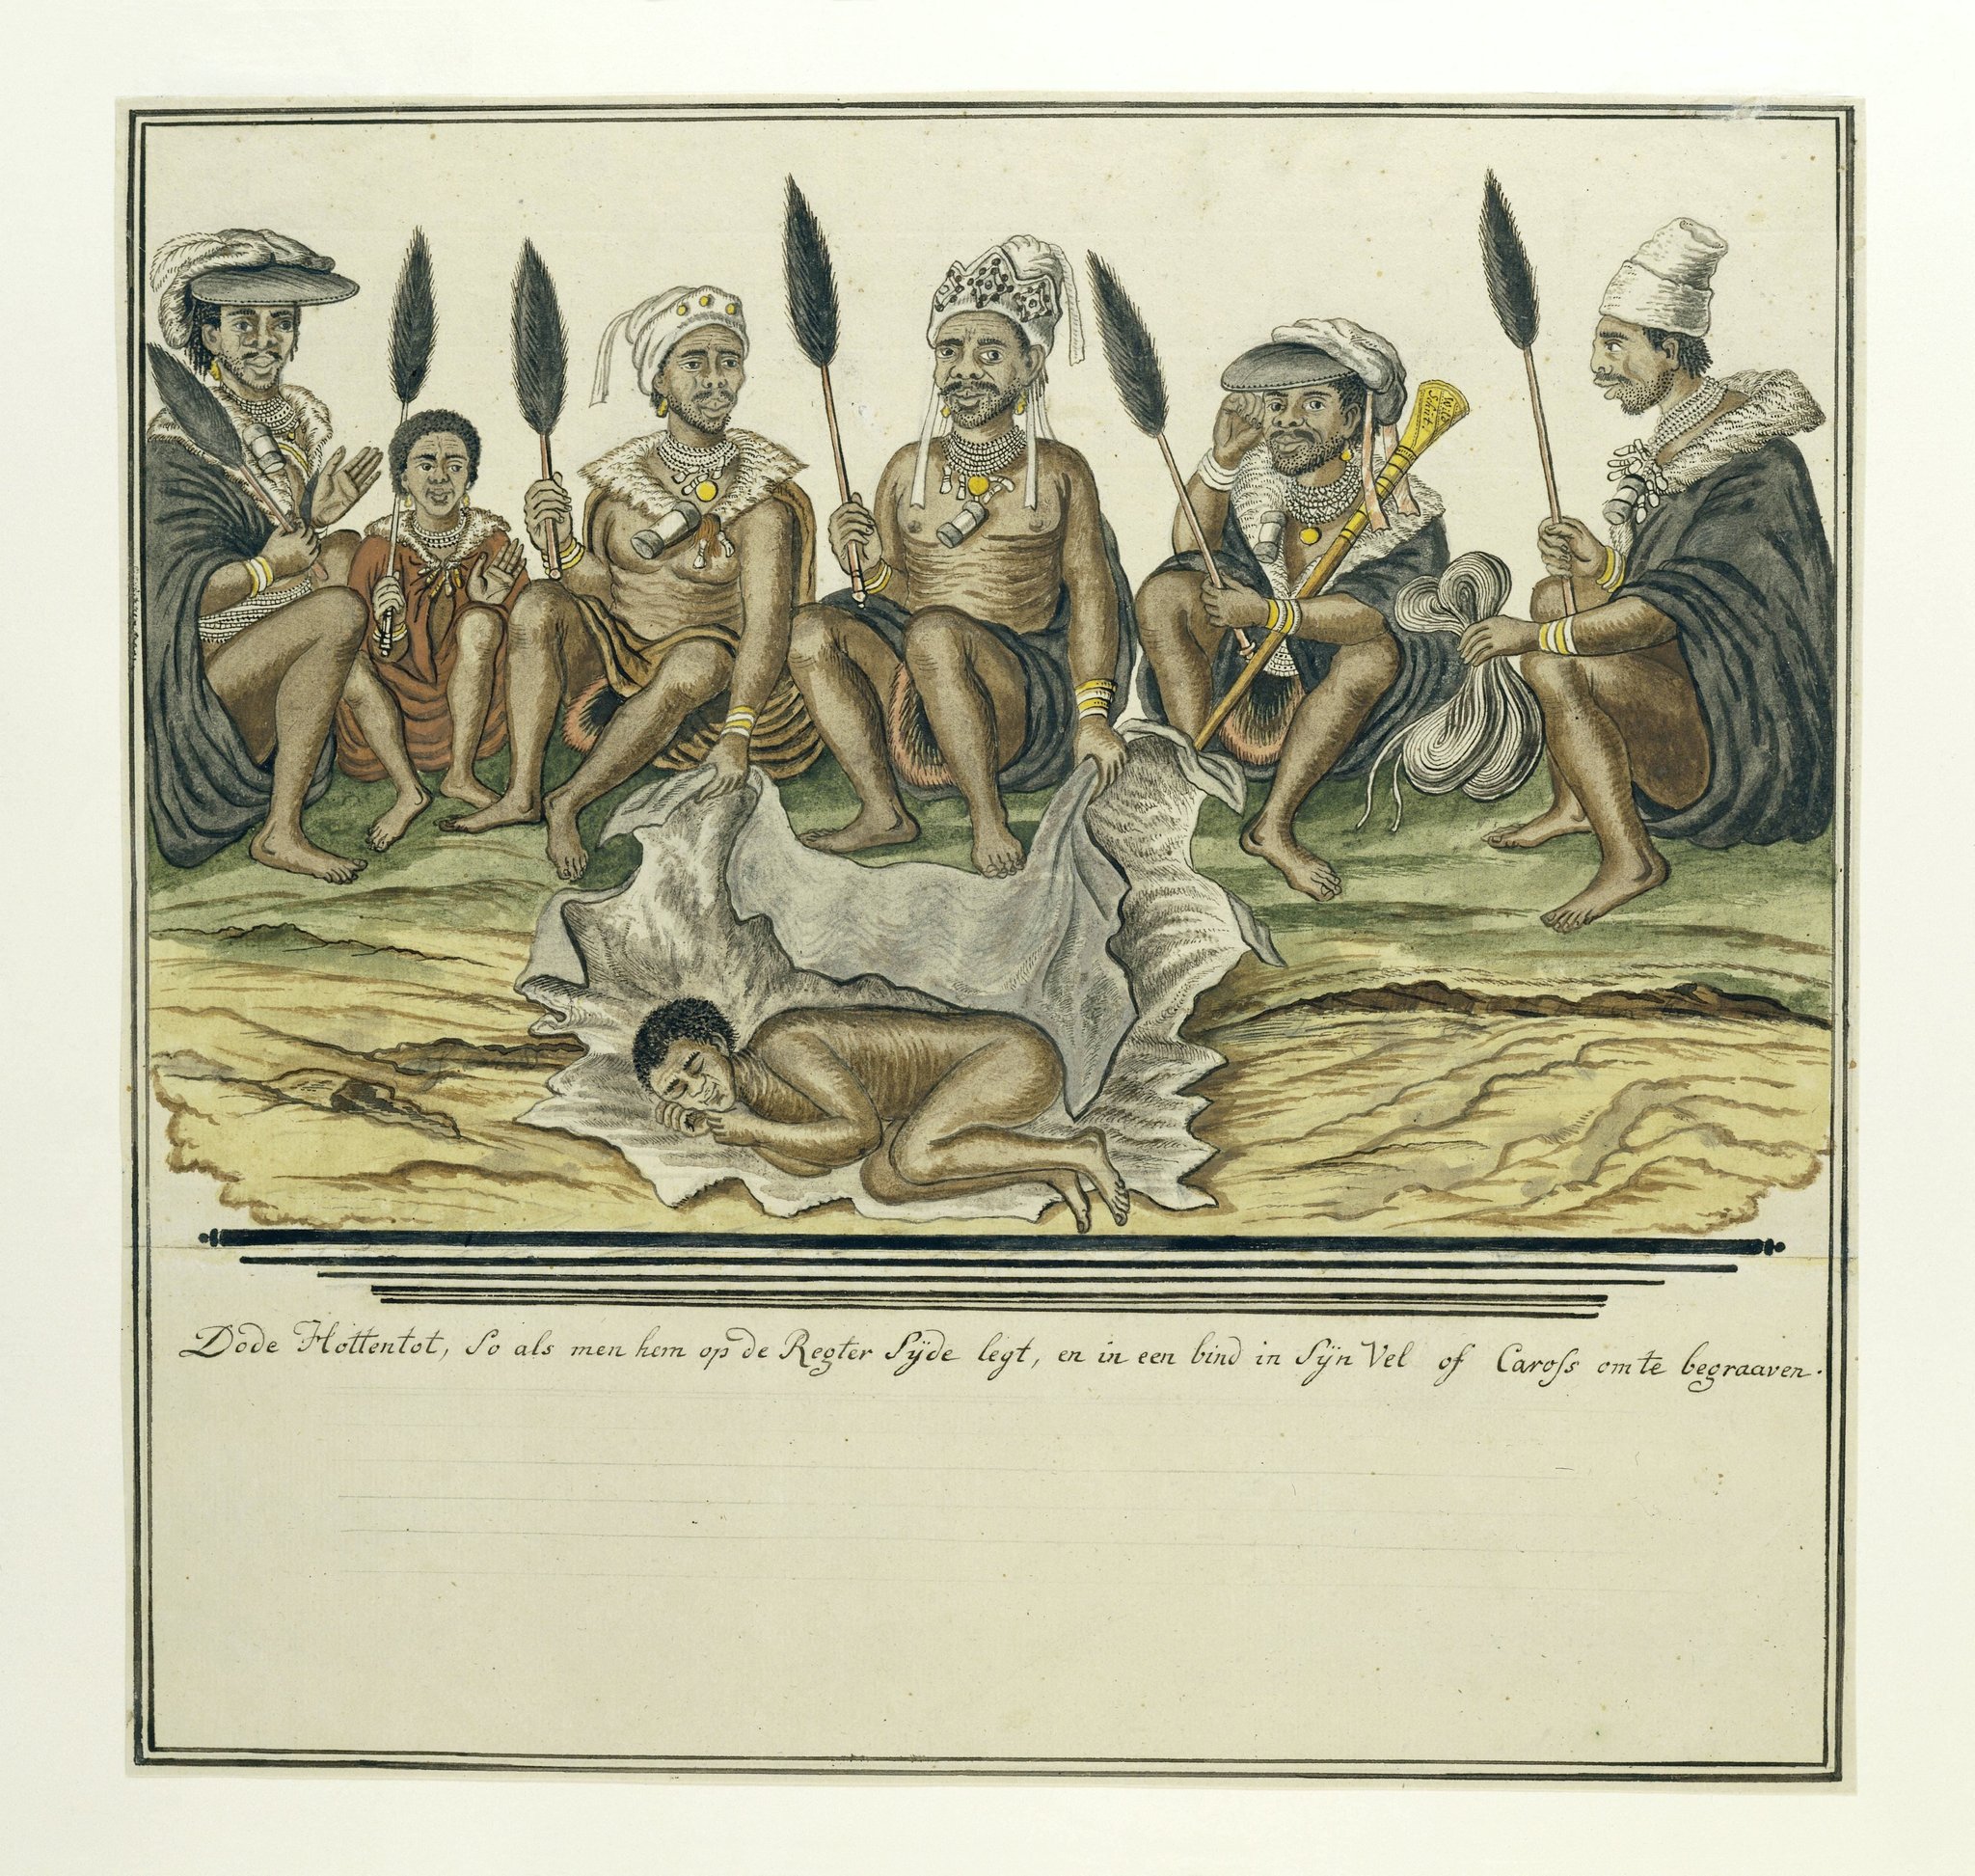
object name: drawing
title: Burial of a Khoikhoi man, with spectators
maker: robert jacob gordon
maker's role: draughtsman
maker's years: 1743-1795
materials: chalk, paint, ink, paper, pencil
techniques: brush, pen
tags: khoikhoi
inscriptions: annotation: ‘Dode Hottentot, So als men hem op de Regter Sijde legt, en in een bind in Sijn Vel of Caroß om te begraaven.’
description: Een dode Khoi wordt in een dierenvel gewikkeld De dode wordt in een dierenvel gewikkeld voor zijn begrafenis. Een van de aanwezigen is capitein Wildschut, met zijn van de VOC ontvangen waardigheidsstaf in de hand.